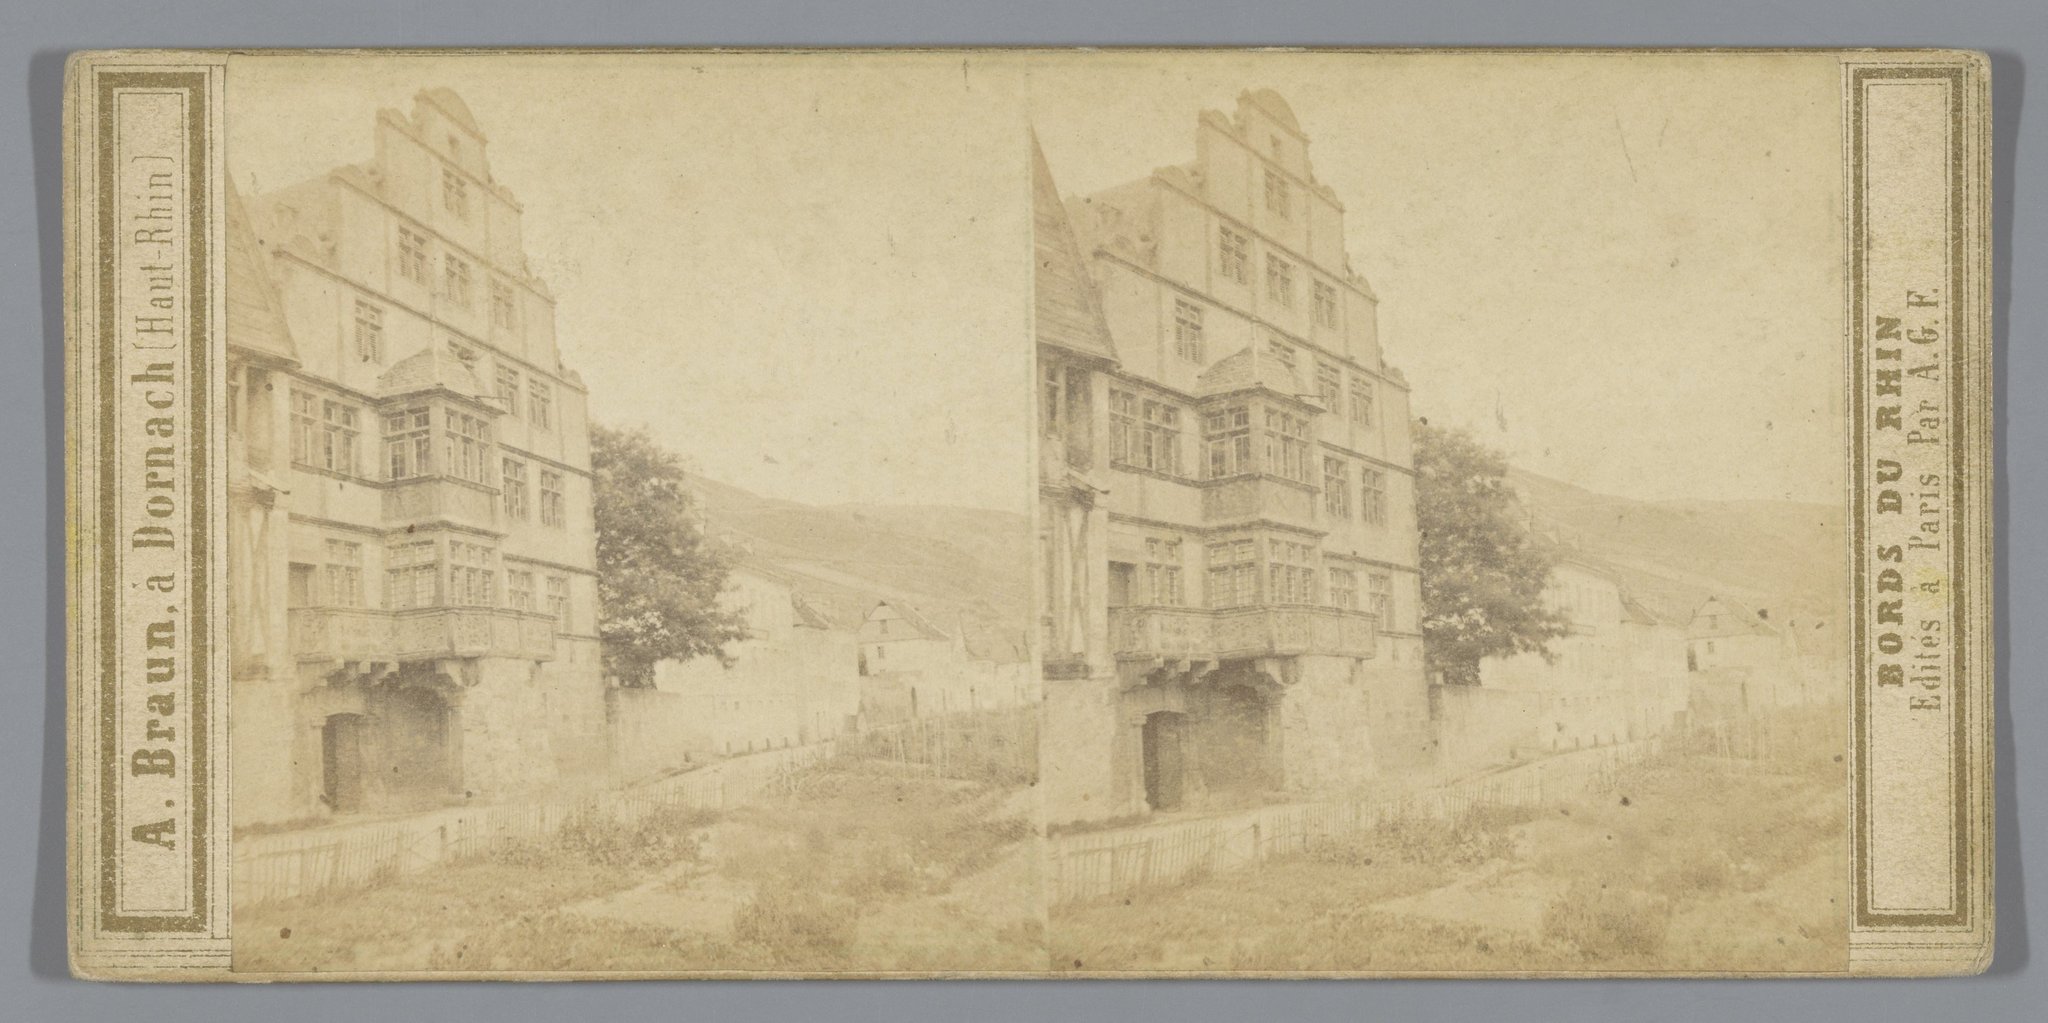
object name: stereograph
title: Ancienne Maison à Lorch / Altes Haus in Lorch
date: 1860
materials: cardboard, paper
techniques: albumen print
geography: dornach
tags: façade (of house or building)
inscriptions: number: ‘868.’, inscription: ‘8/ 50/ 20 cts n’